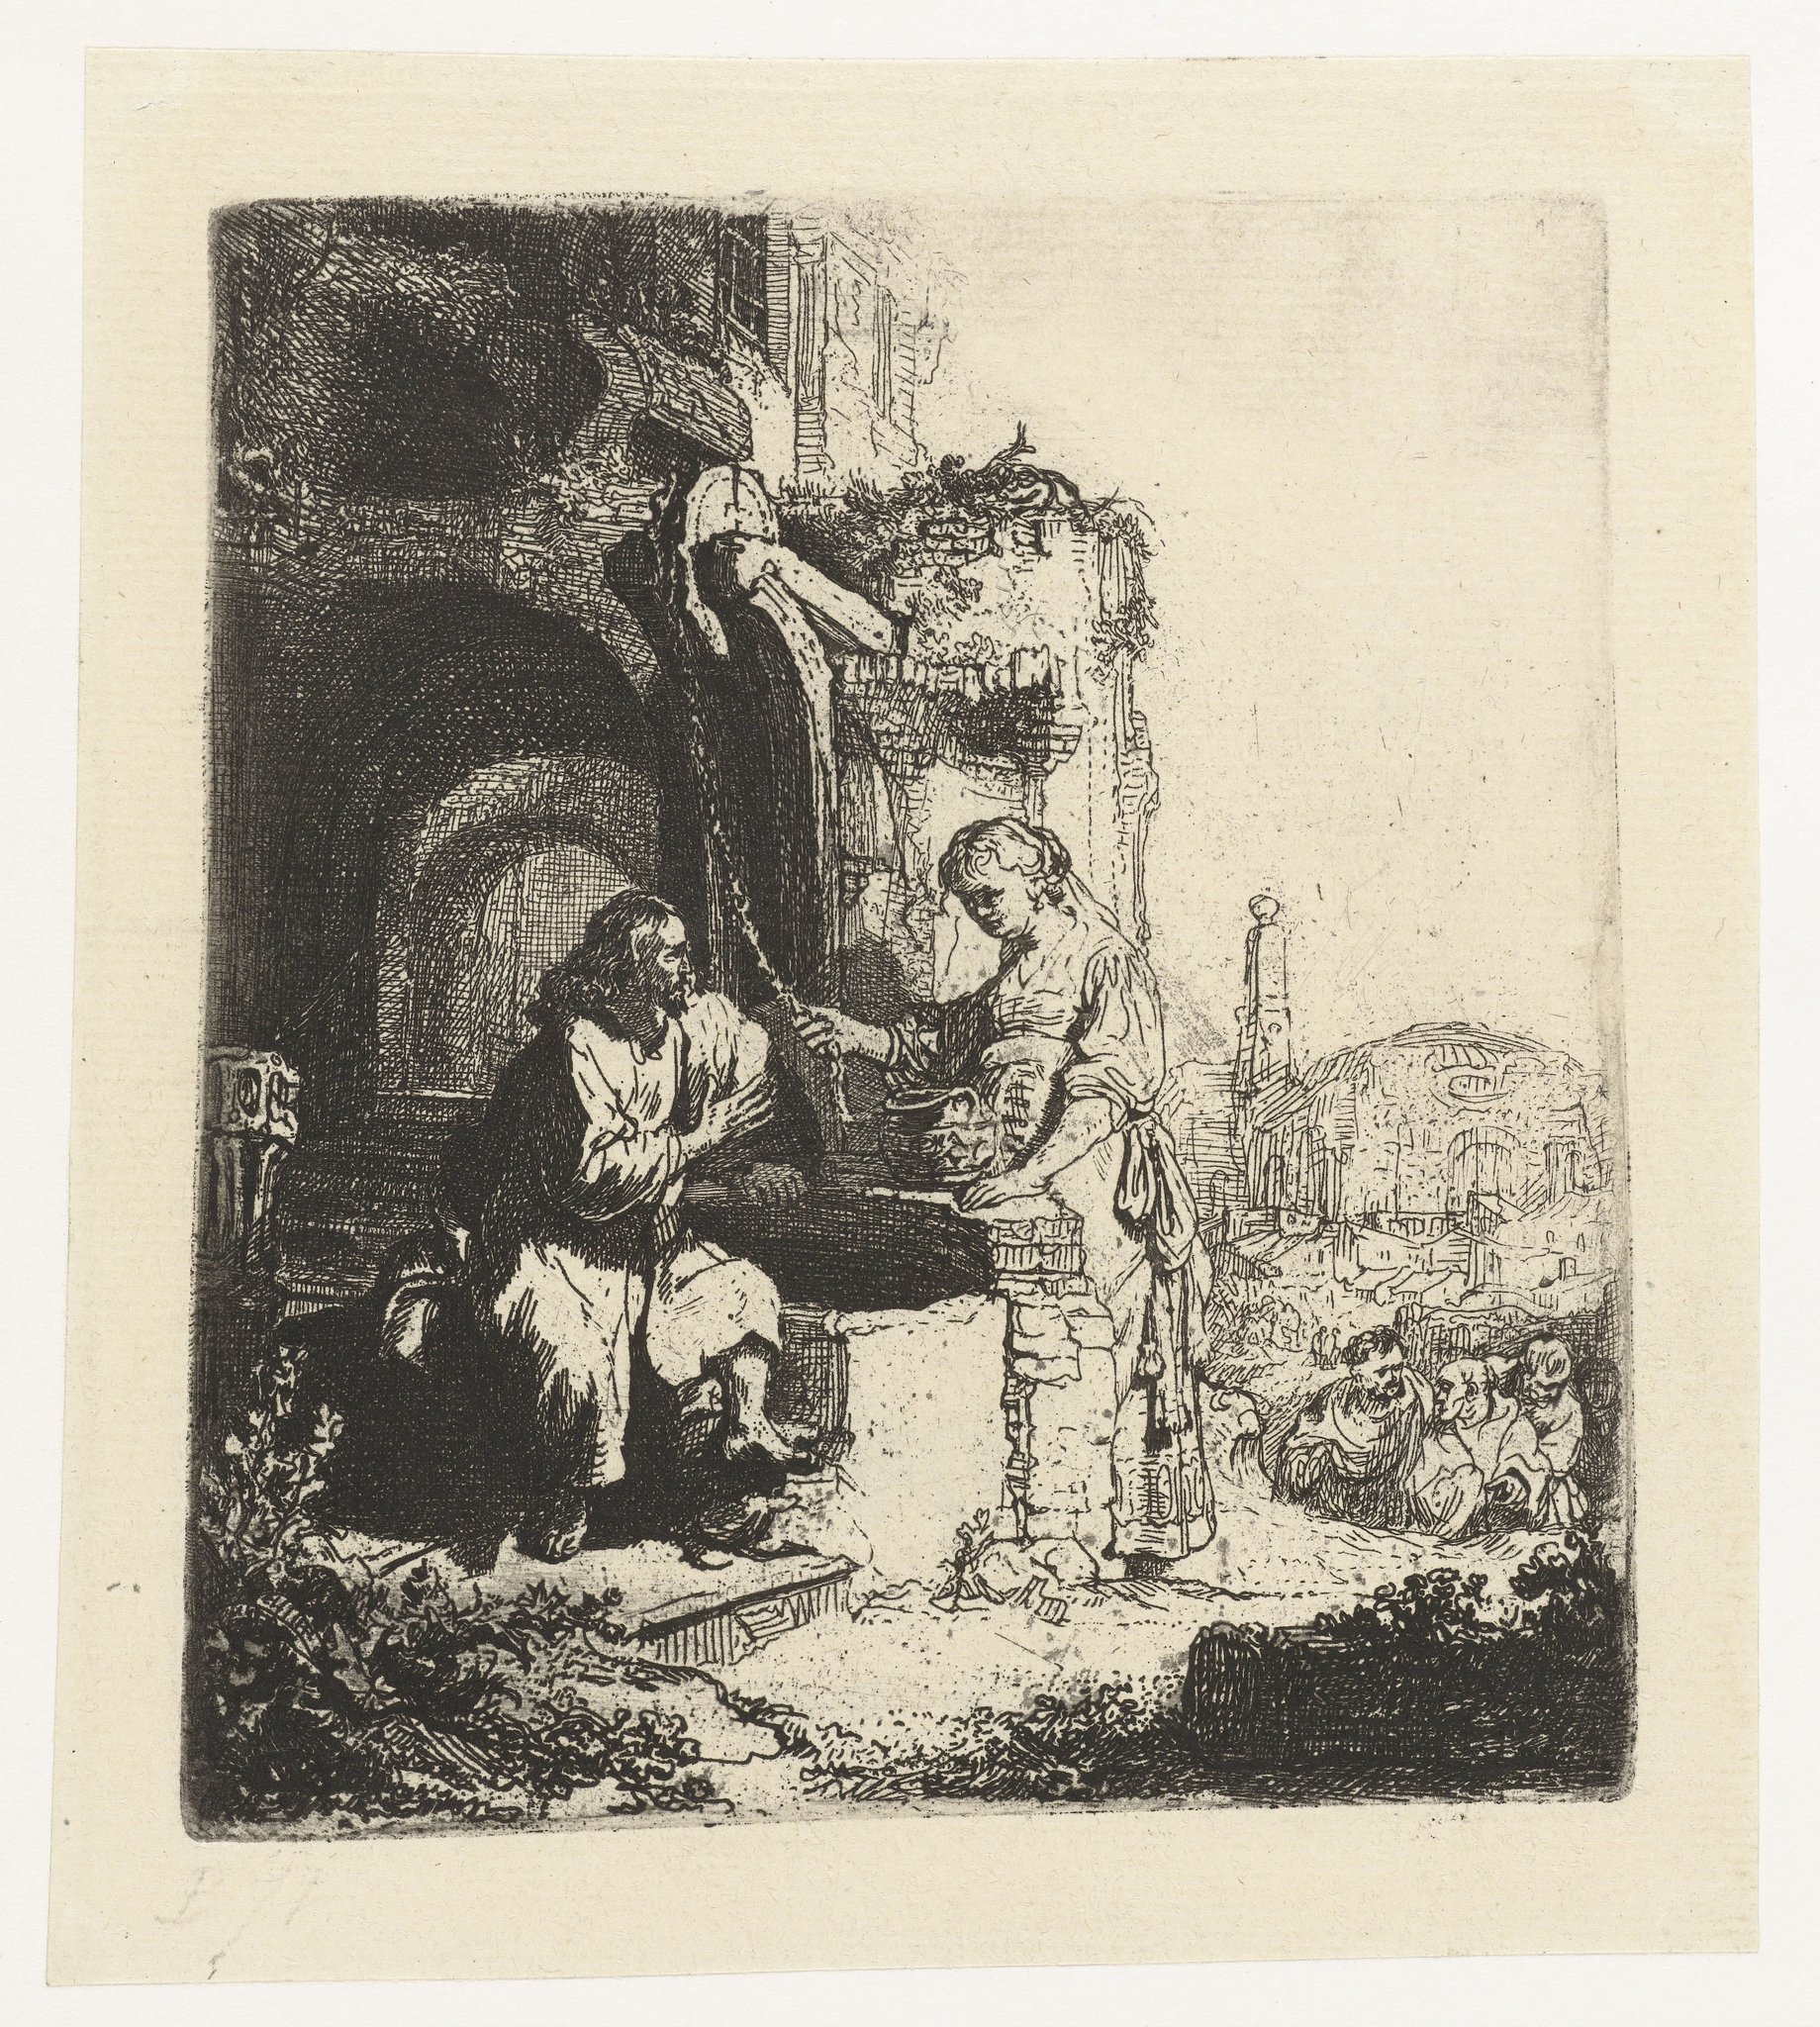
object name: print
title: Christ and the woman of Samaria among ruins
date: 1634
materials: paper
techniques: etching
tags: christ and the woman of samaria: sitting at jacob's well he asks her for a drink from her jug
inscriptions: inscription: ‘Coppier’